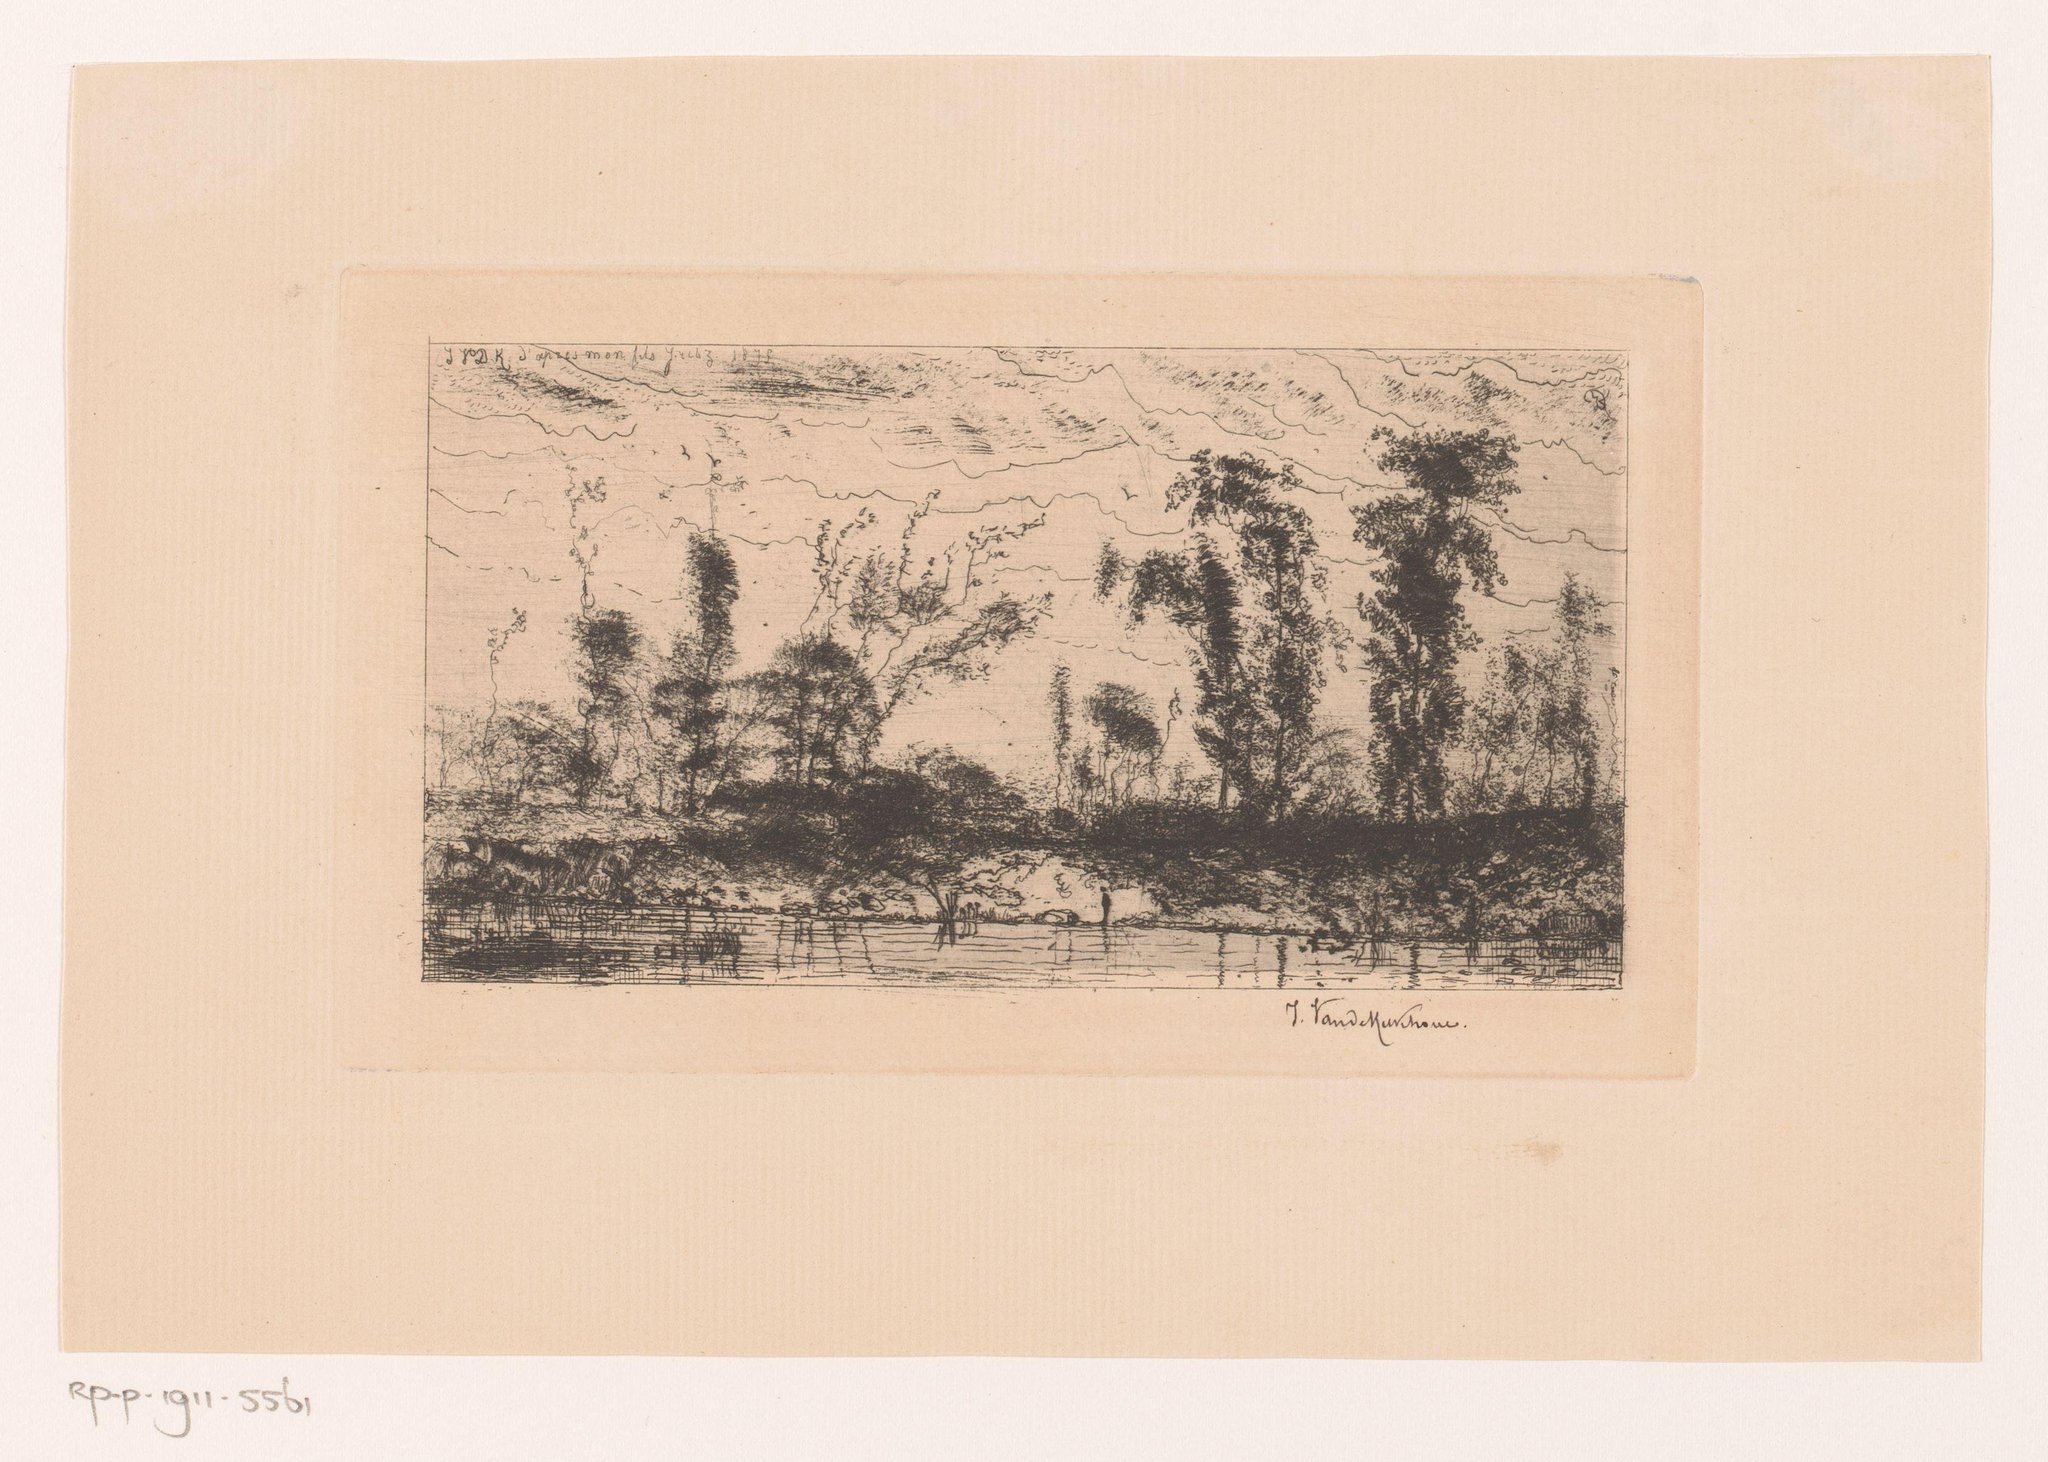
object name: print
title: Figuur op de oever van een rivier met bomen op de achtergrond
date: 1876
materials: paper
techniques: etching, intaglio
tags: river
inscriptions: collector's mark: Lugt 2228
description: De etsen naar de schilderijen van Frédéric Van de Kerkhove werden na zijn dood door zijn vader en zuster gemaakt en uitgegeven in twee reeksen. De eerste werd in 1877 uitgegeven door het Journal des Beaux-Arts et de la Littérature: Cahier de 25 Eaux-fortes d'après Frédéric van de Kerkhove, gravées par son père et sa sœur. De tweede reeks van 126 etsen, ook in 1877, werd in Parijs uitgegeven bij A. Lévy onder de titel Cent eaux-fortes gravées par J. Van de Kerkhove d'après les tableaux de Frédéric Van de Kerkhove, mort en 1873 à l'âge de 10 ans et 11 mois.